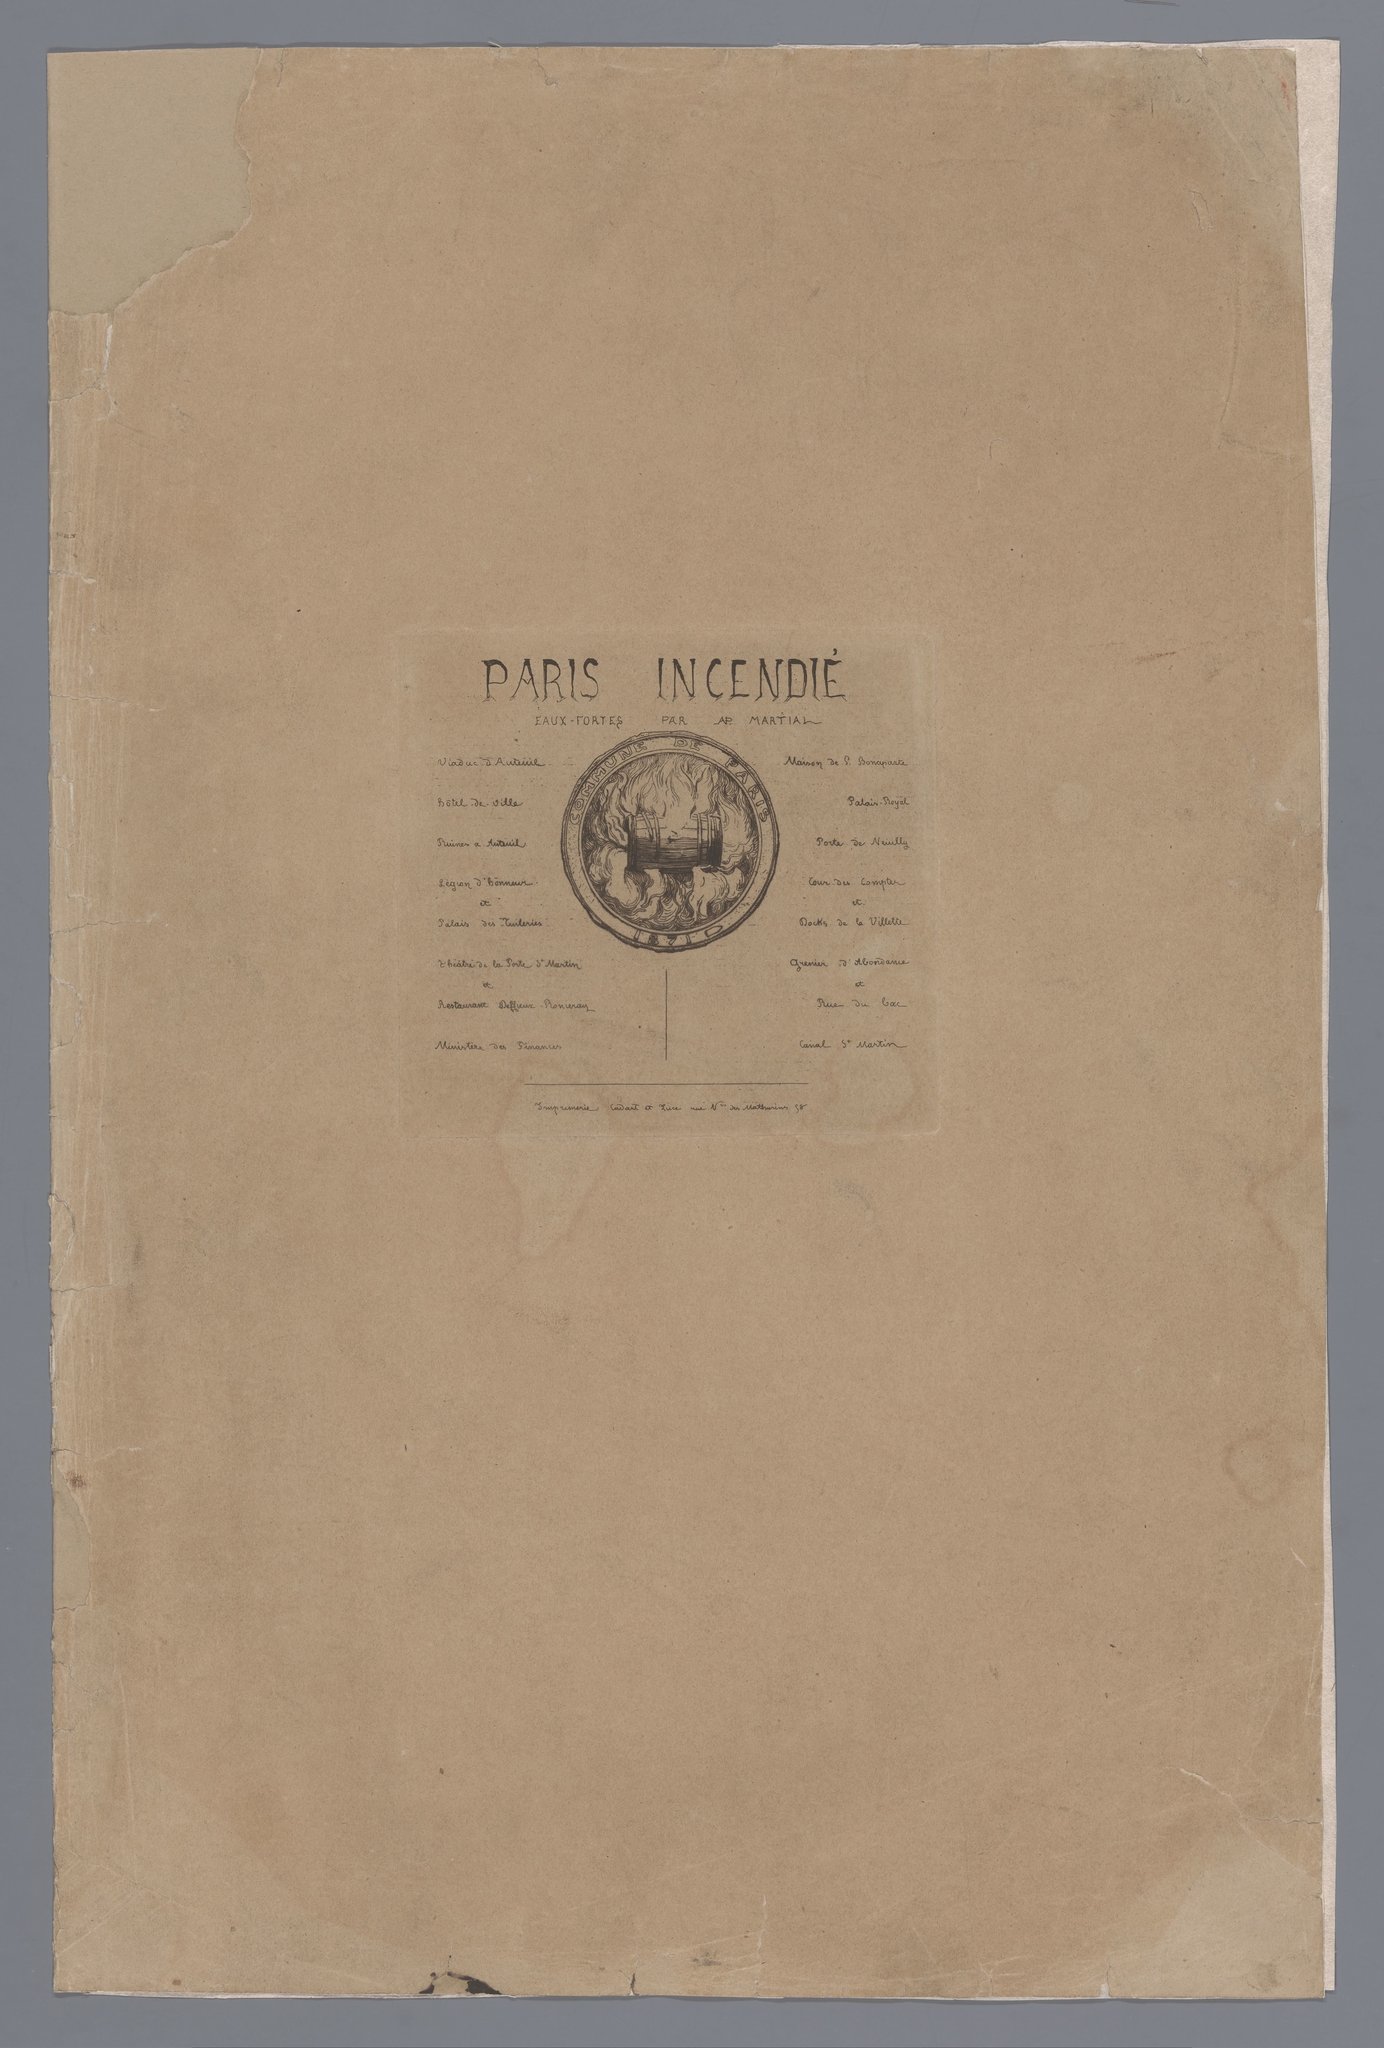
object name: wrapper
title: Commune de Paris 1871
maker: adolphe martial potémont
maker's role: print maker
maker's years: 1828-1883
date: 1871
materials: paper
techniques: etching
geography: paris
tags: on fire, ablaze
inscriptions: date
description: In deze omslag bevindt zich een twaalfdelige serie prenten met als onderwerp het brandende Parijs tijdens de Commune in 1871, samengesteld en uitgevoerd door Martial Potémont.